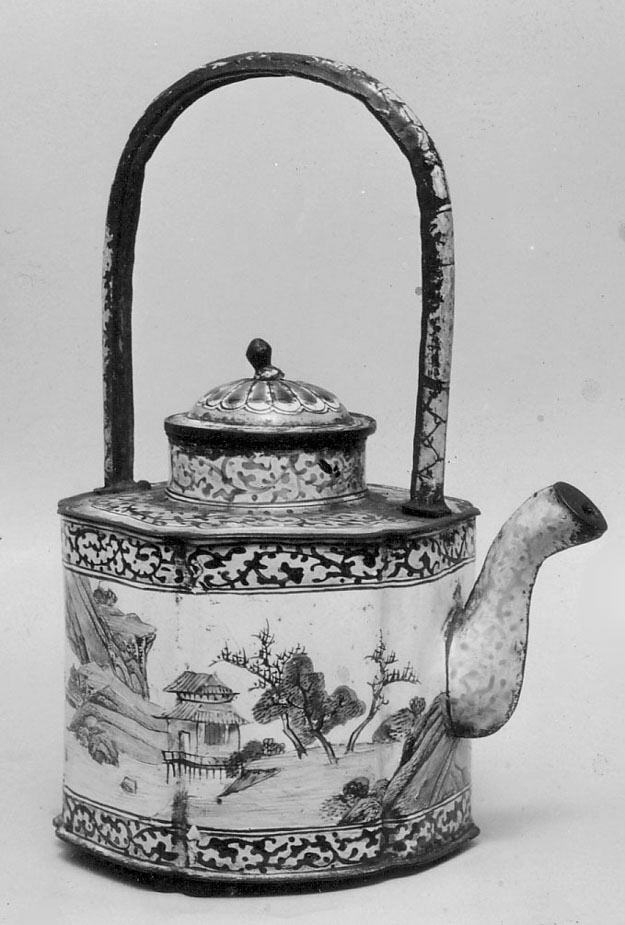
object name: covered wine pot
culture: chinese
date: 1801-1900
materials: enamel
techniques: painting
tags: buildings,trees